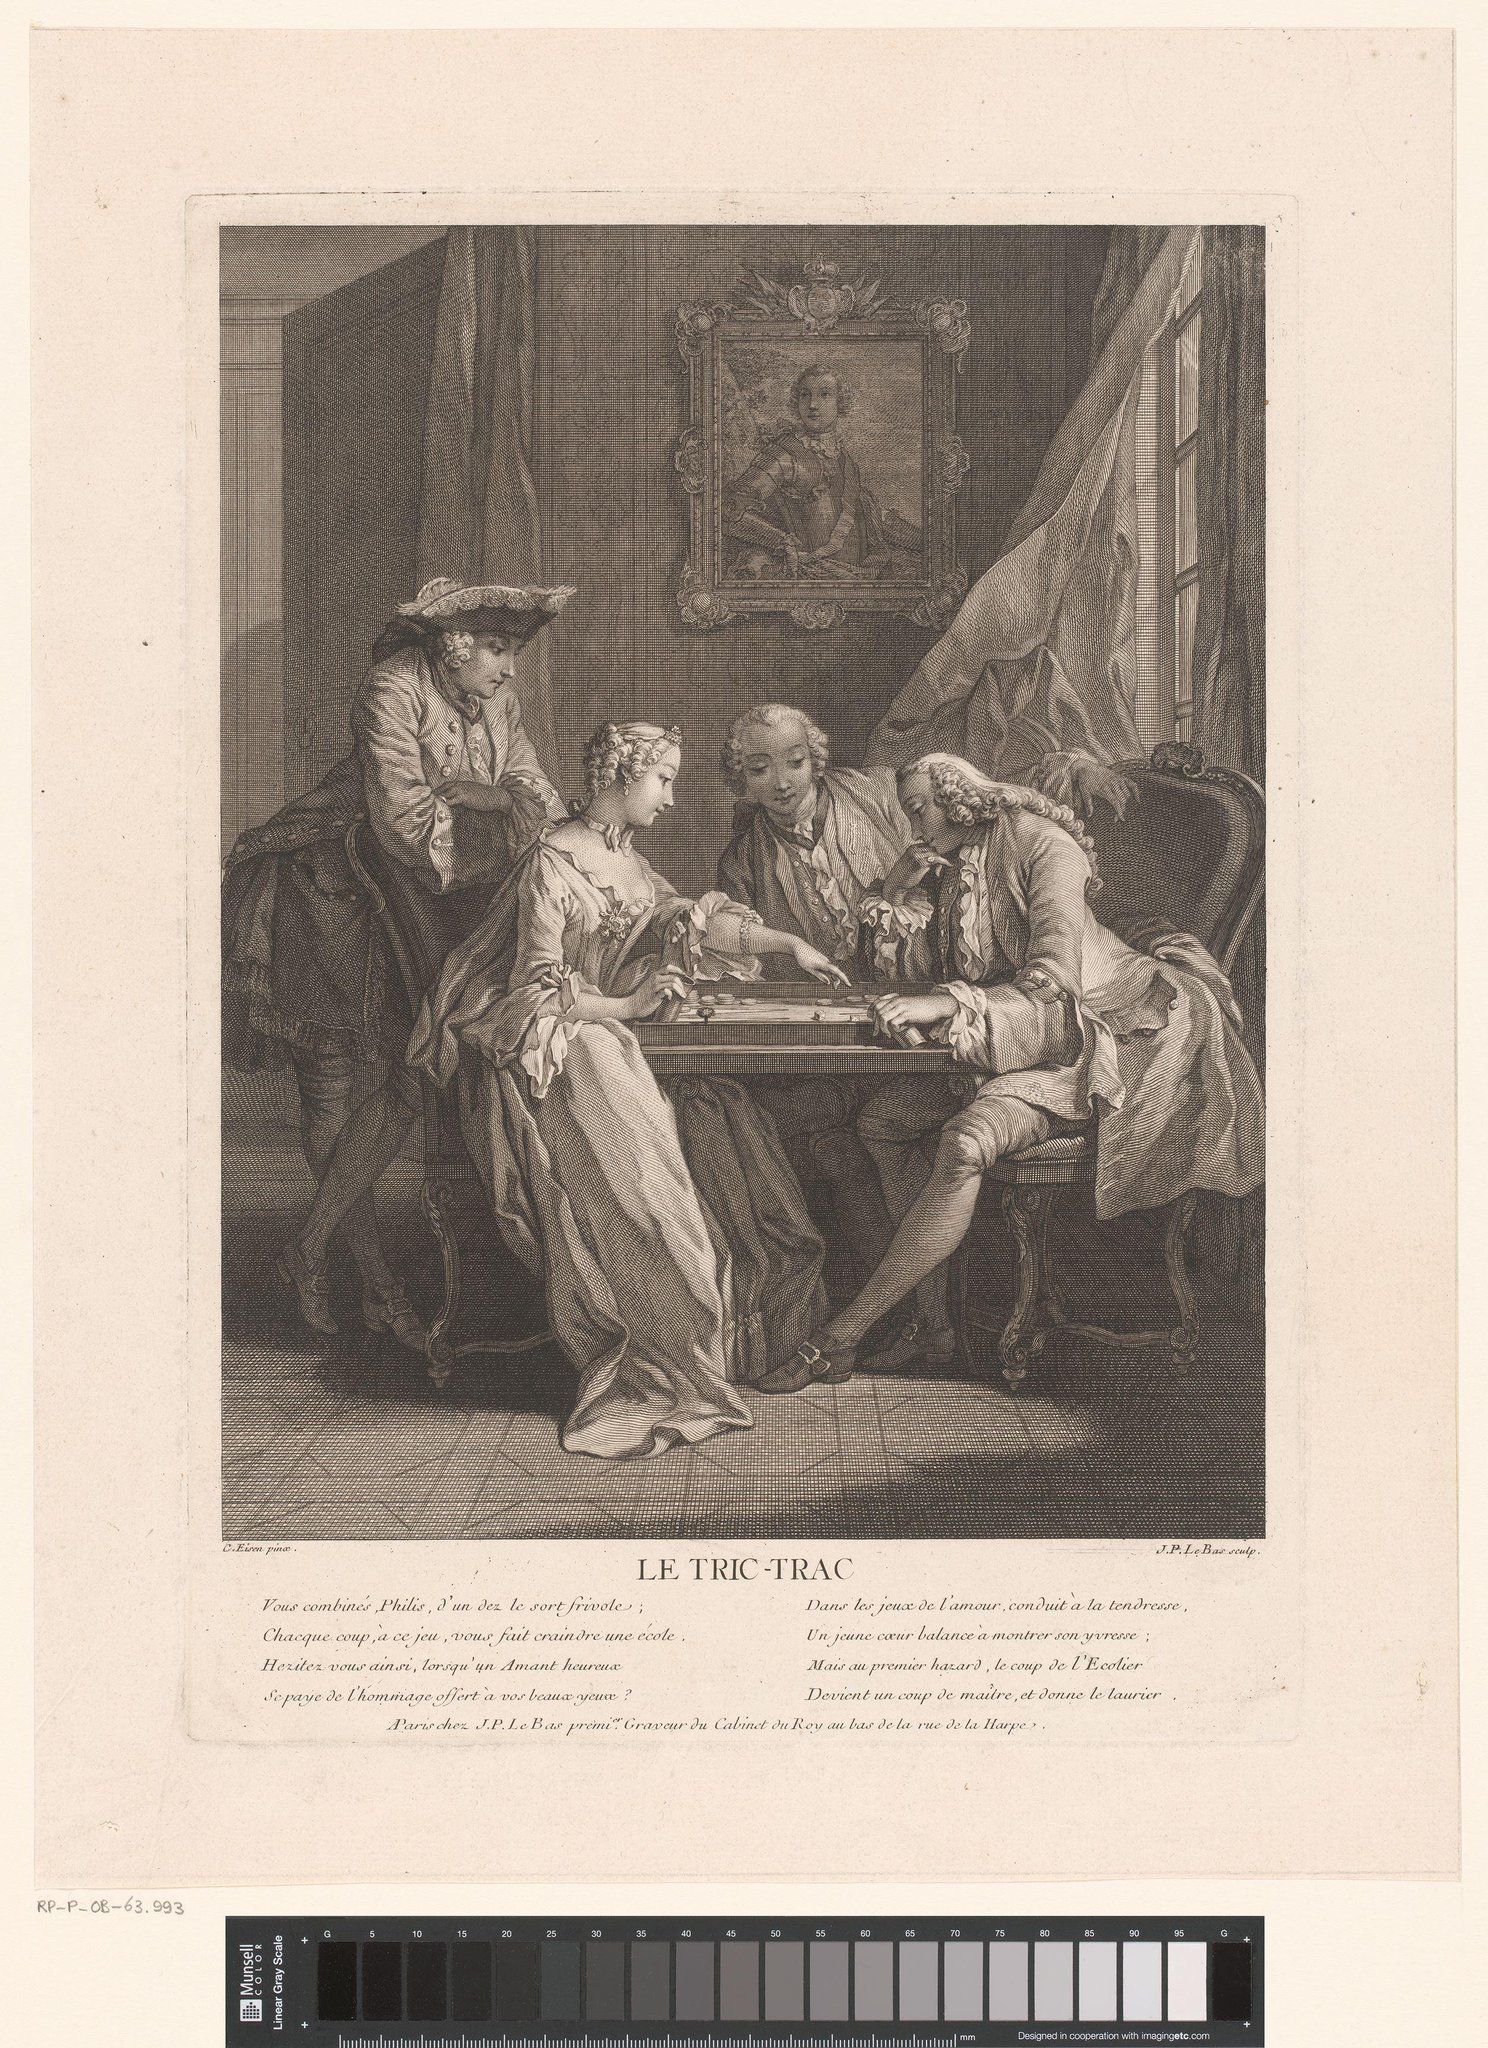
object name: print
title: Saloninterieur met triktrakspelend gezelschap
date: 1730-1783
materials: paper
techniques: engraving, etching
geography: france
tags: drawing-room, 'salon', picture within picture, backgammon, tric-trac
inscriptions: collector's mark: Lugt 240